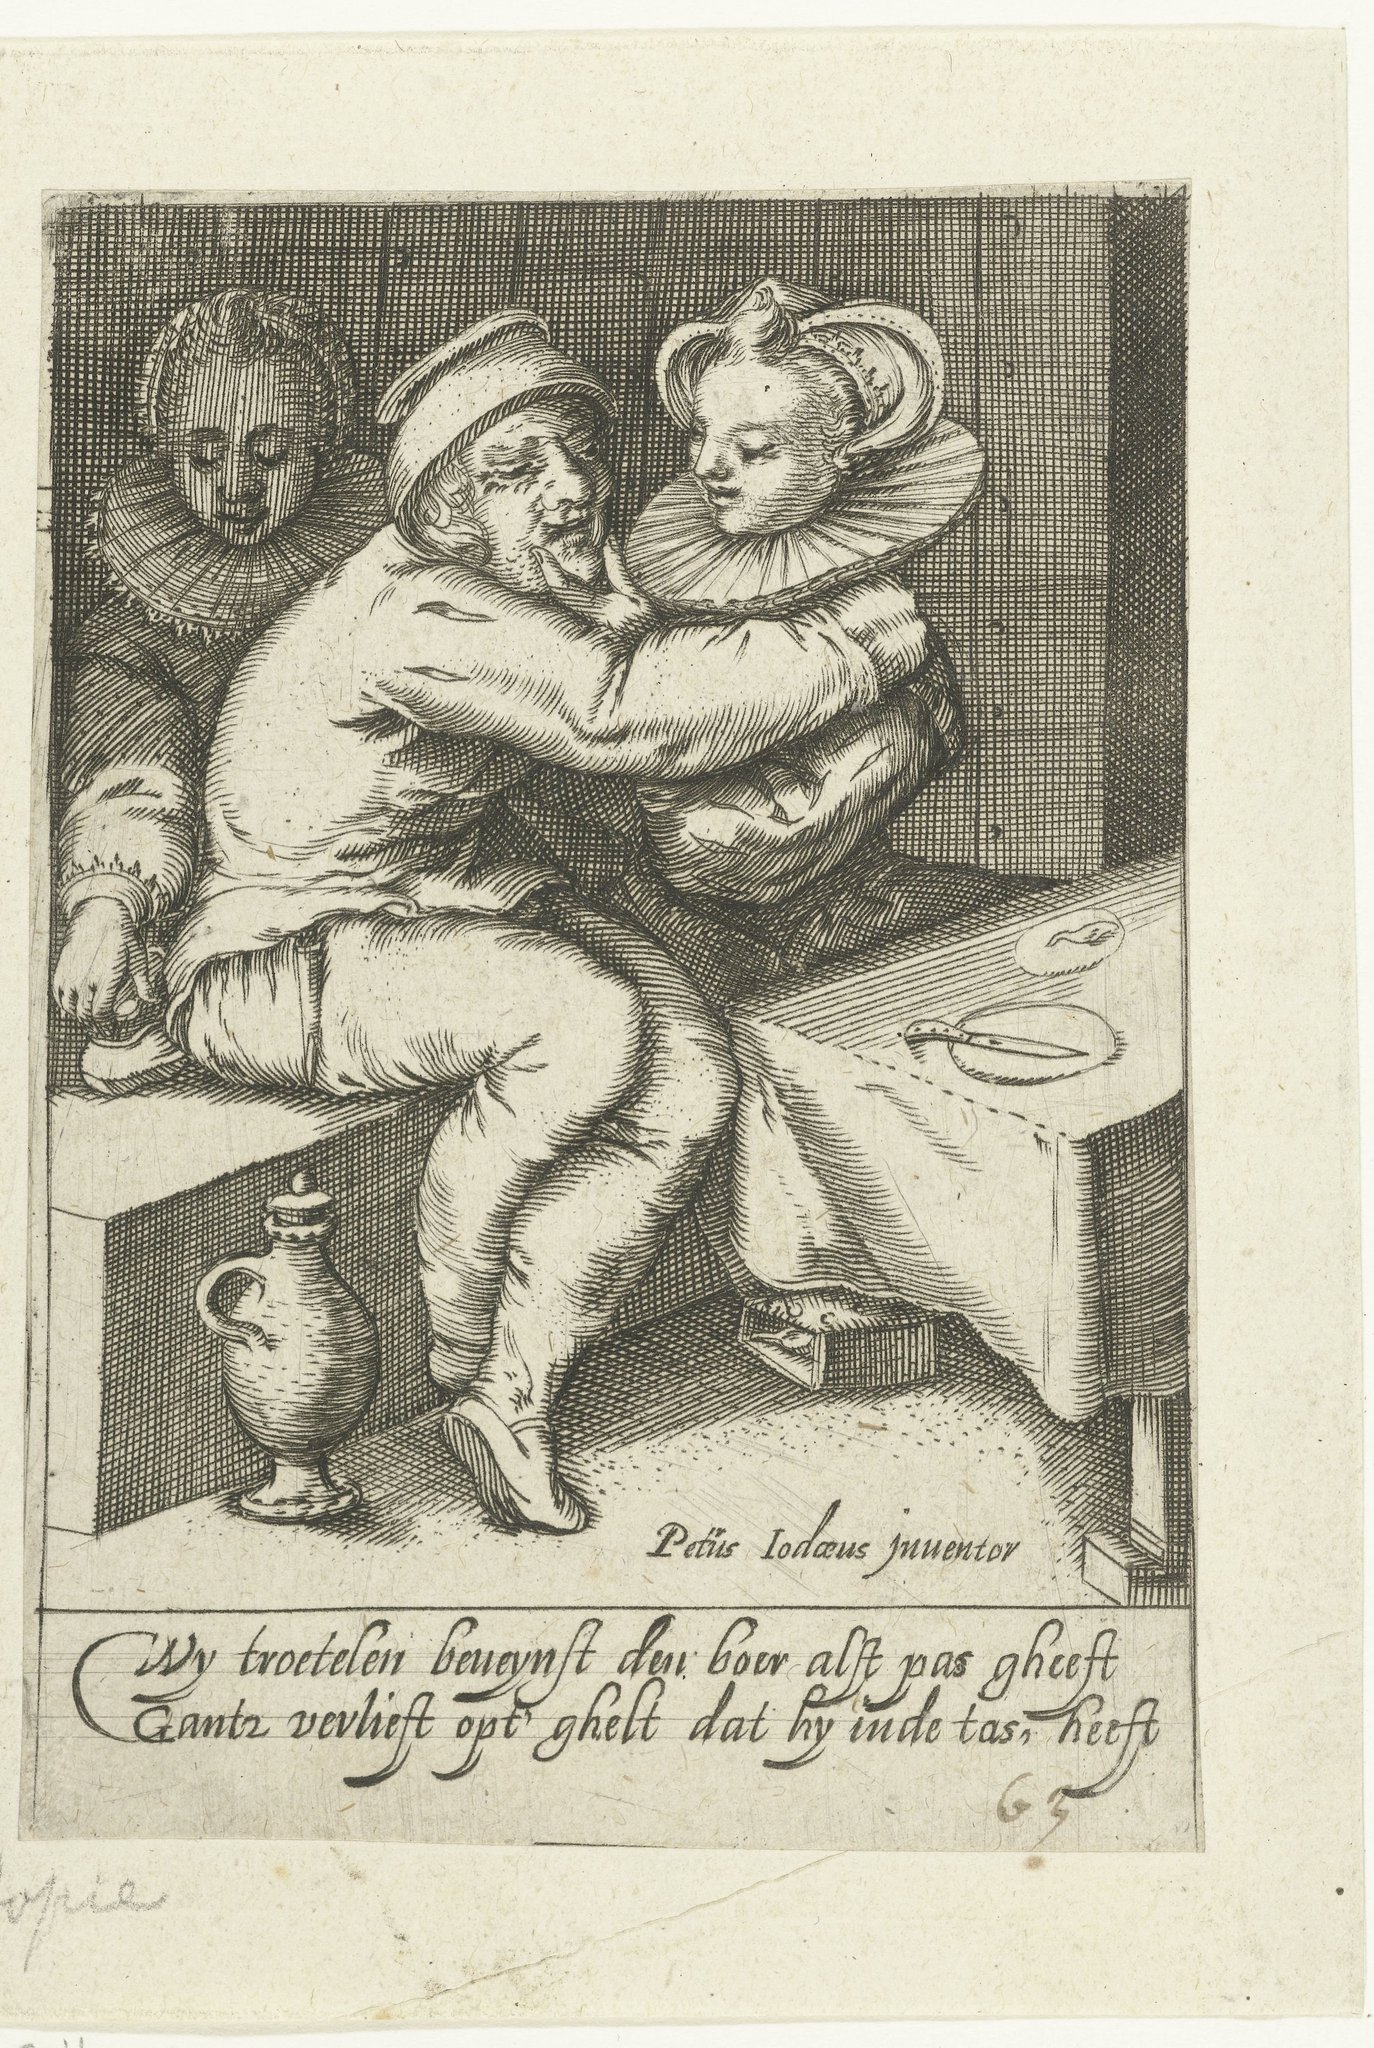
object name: print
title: Man in bordeel wordt beroofd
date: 1585-1610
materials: paper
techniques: engraving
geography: netherlands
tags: the man is robbed (brothel scene)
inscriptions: collector's mark: Lugt 240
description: Een vrijer die met een meisje bezig is in een bordeel wordt door een ander meisje beroofd. Ze pakt stiekem zijn beurs uit zijn achterzak. Onder de voorstelling een Nederlands vers.